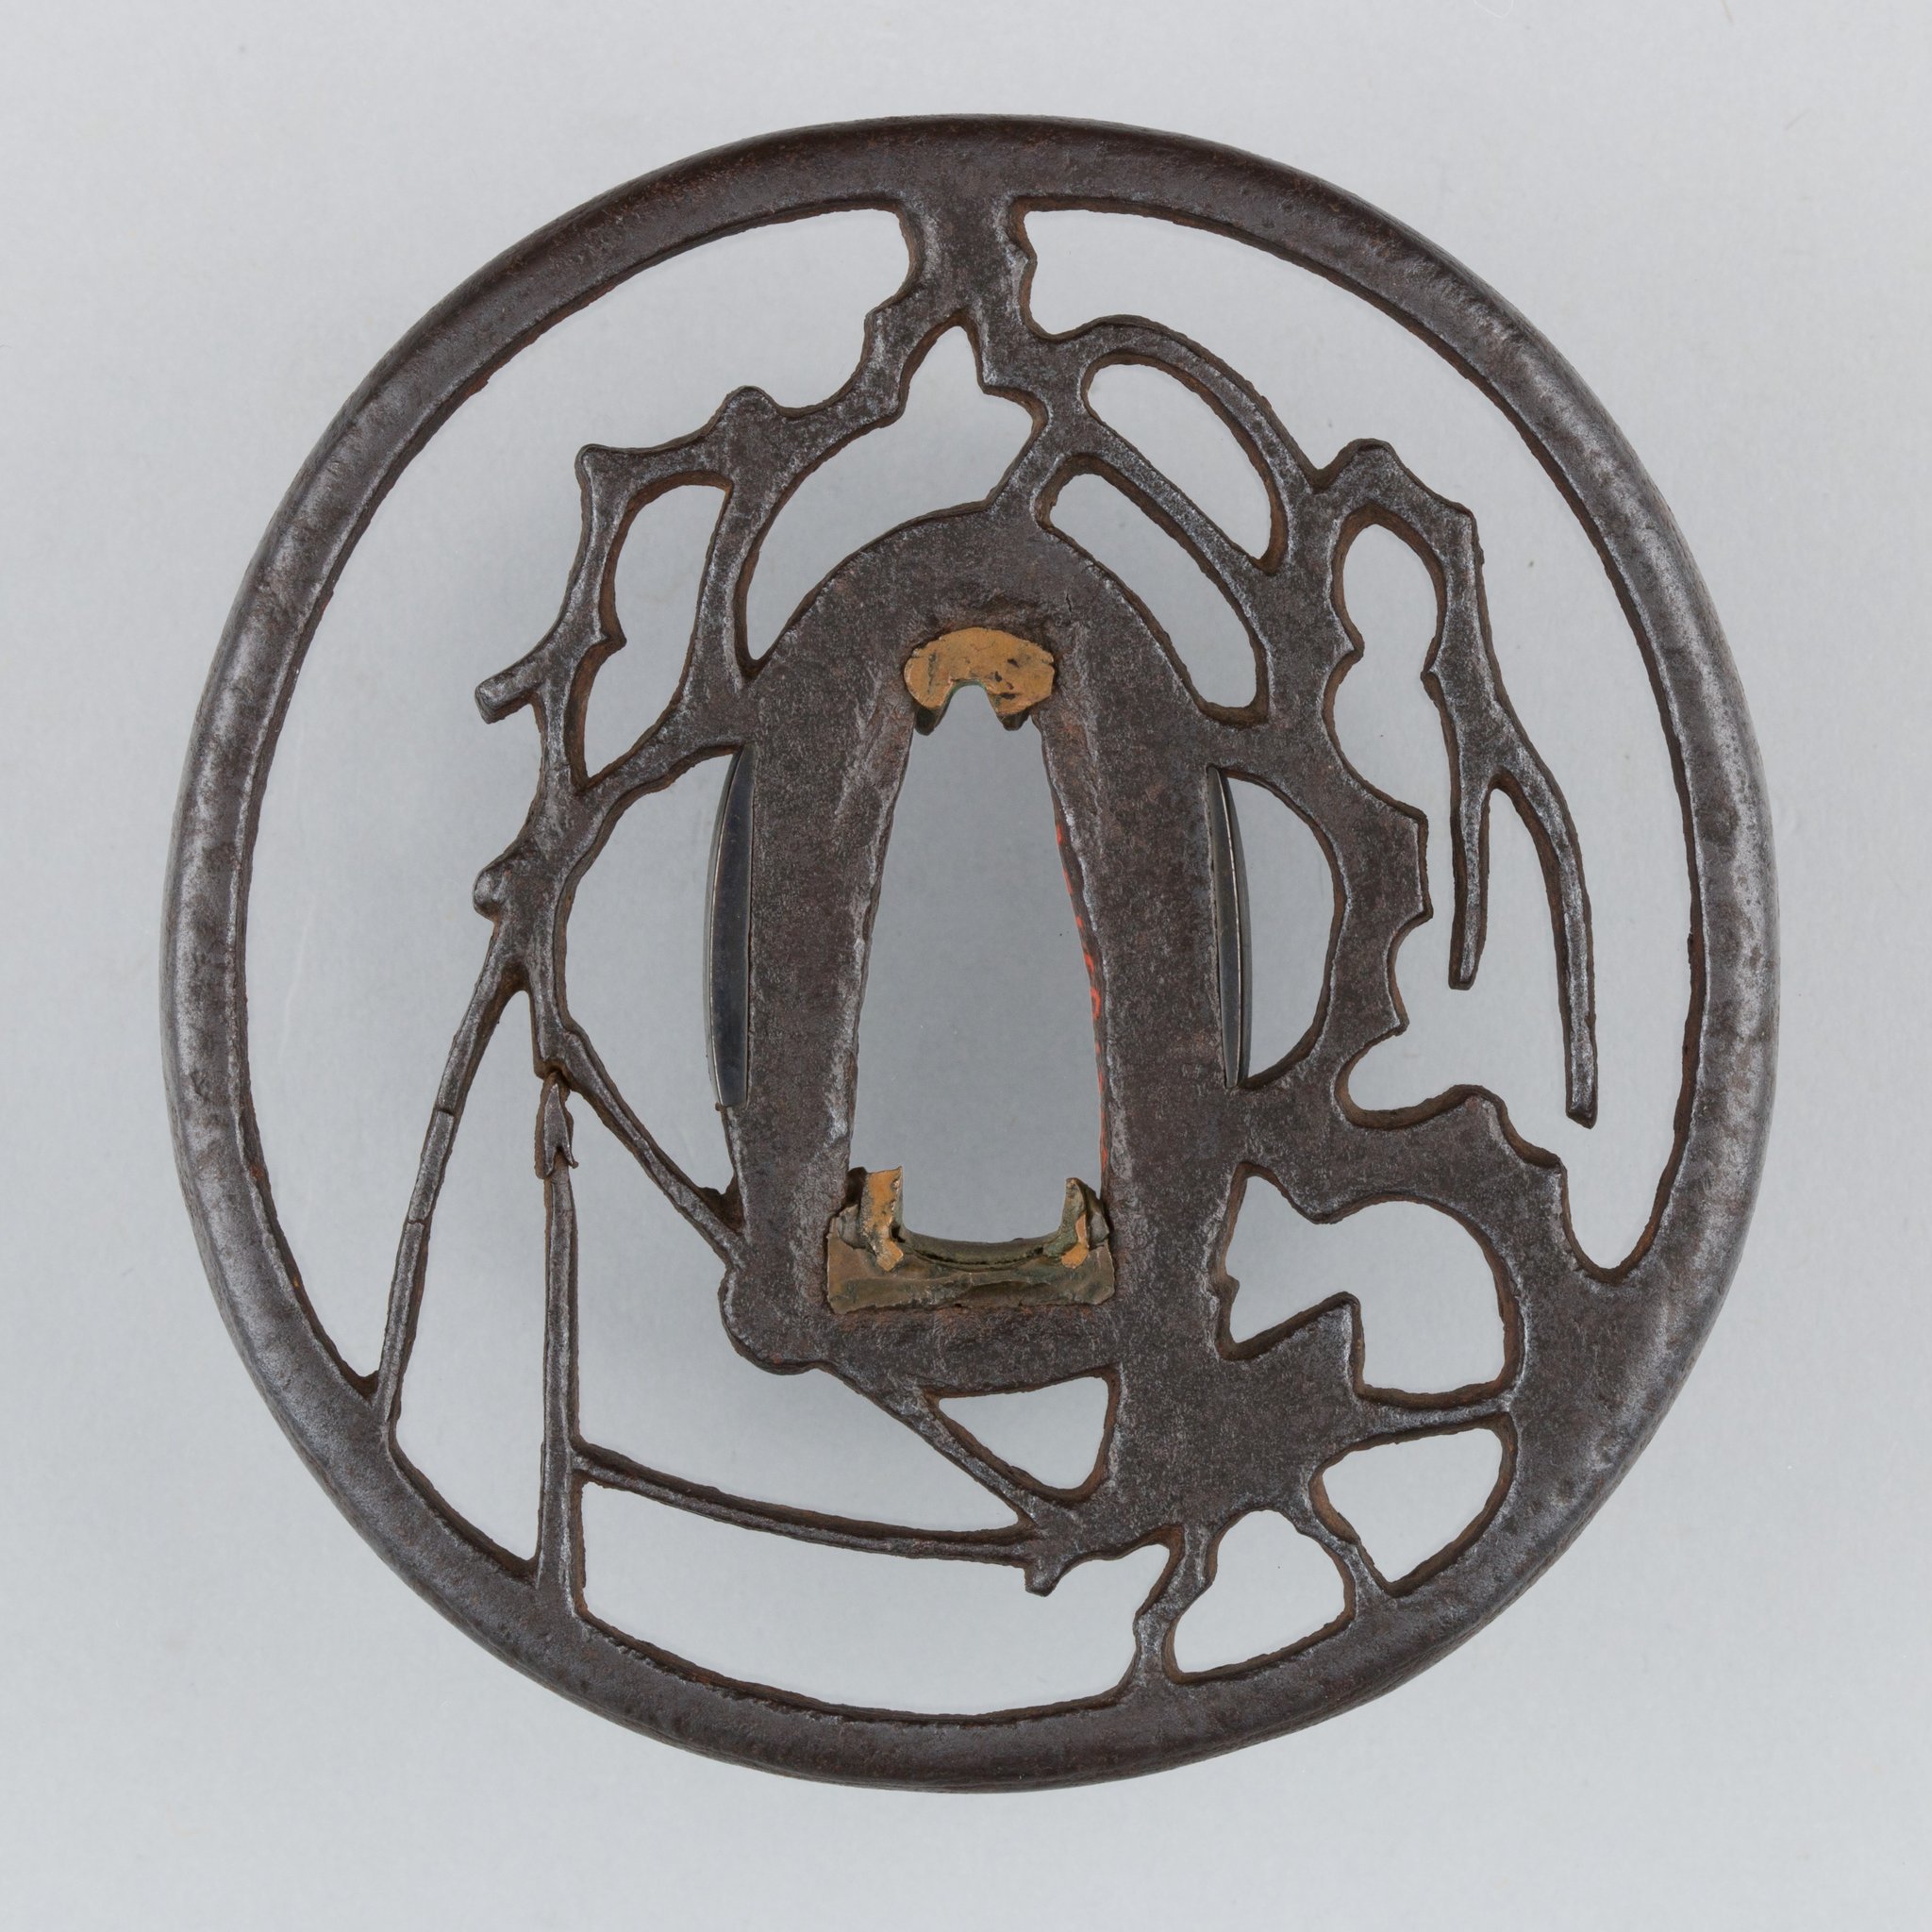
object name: sword guard tsuba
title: Sword Guard (Tsuba)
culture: japanese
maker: akasaka school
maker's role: fittings maker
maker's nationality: japanese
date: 1701-1800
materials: copper, iron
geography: japan